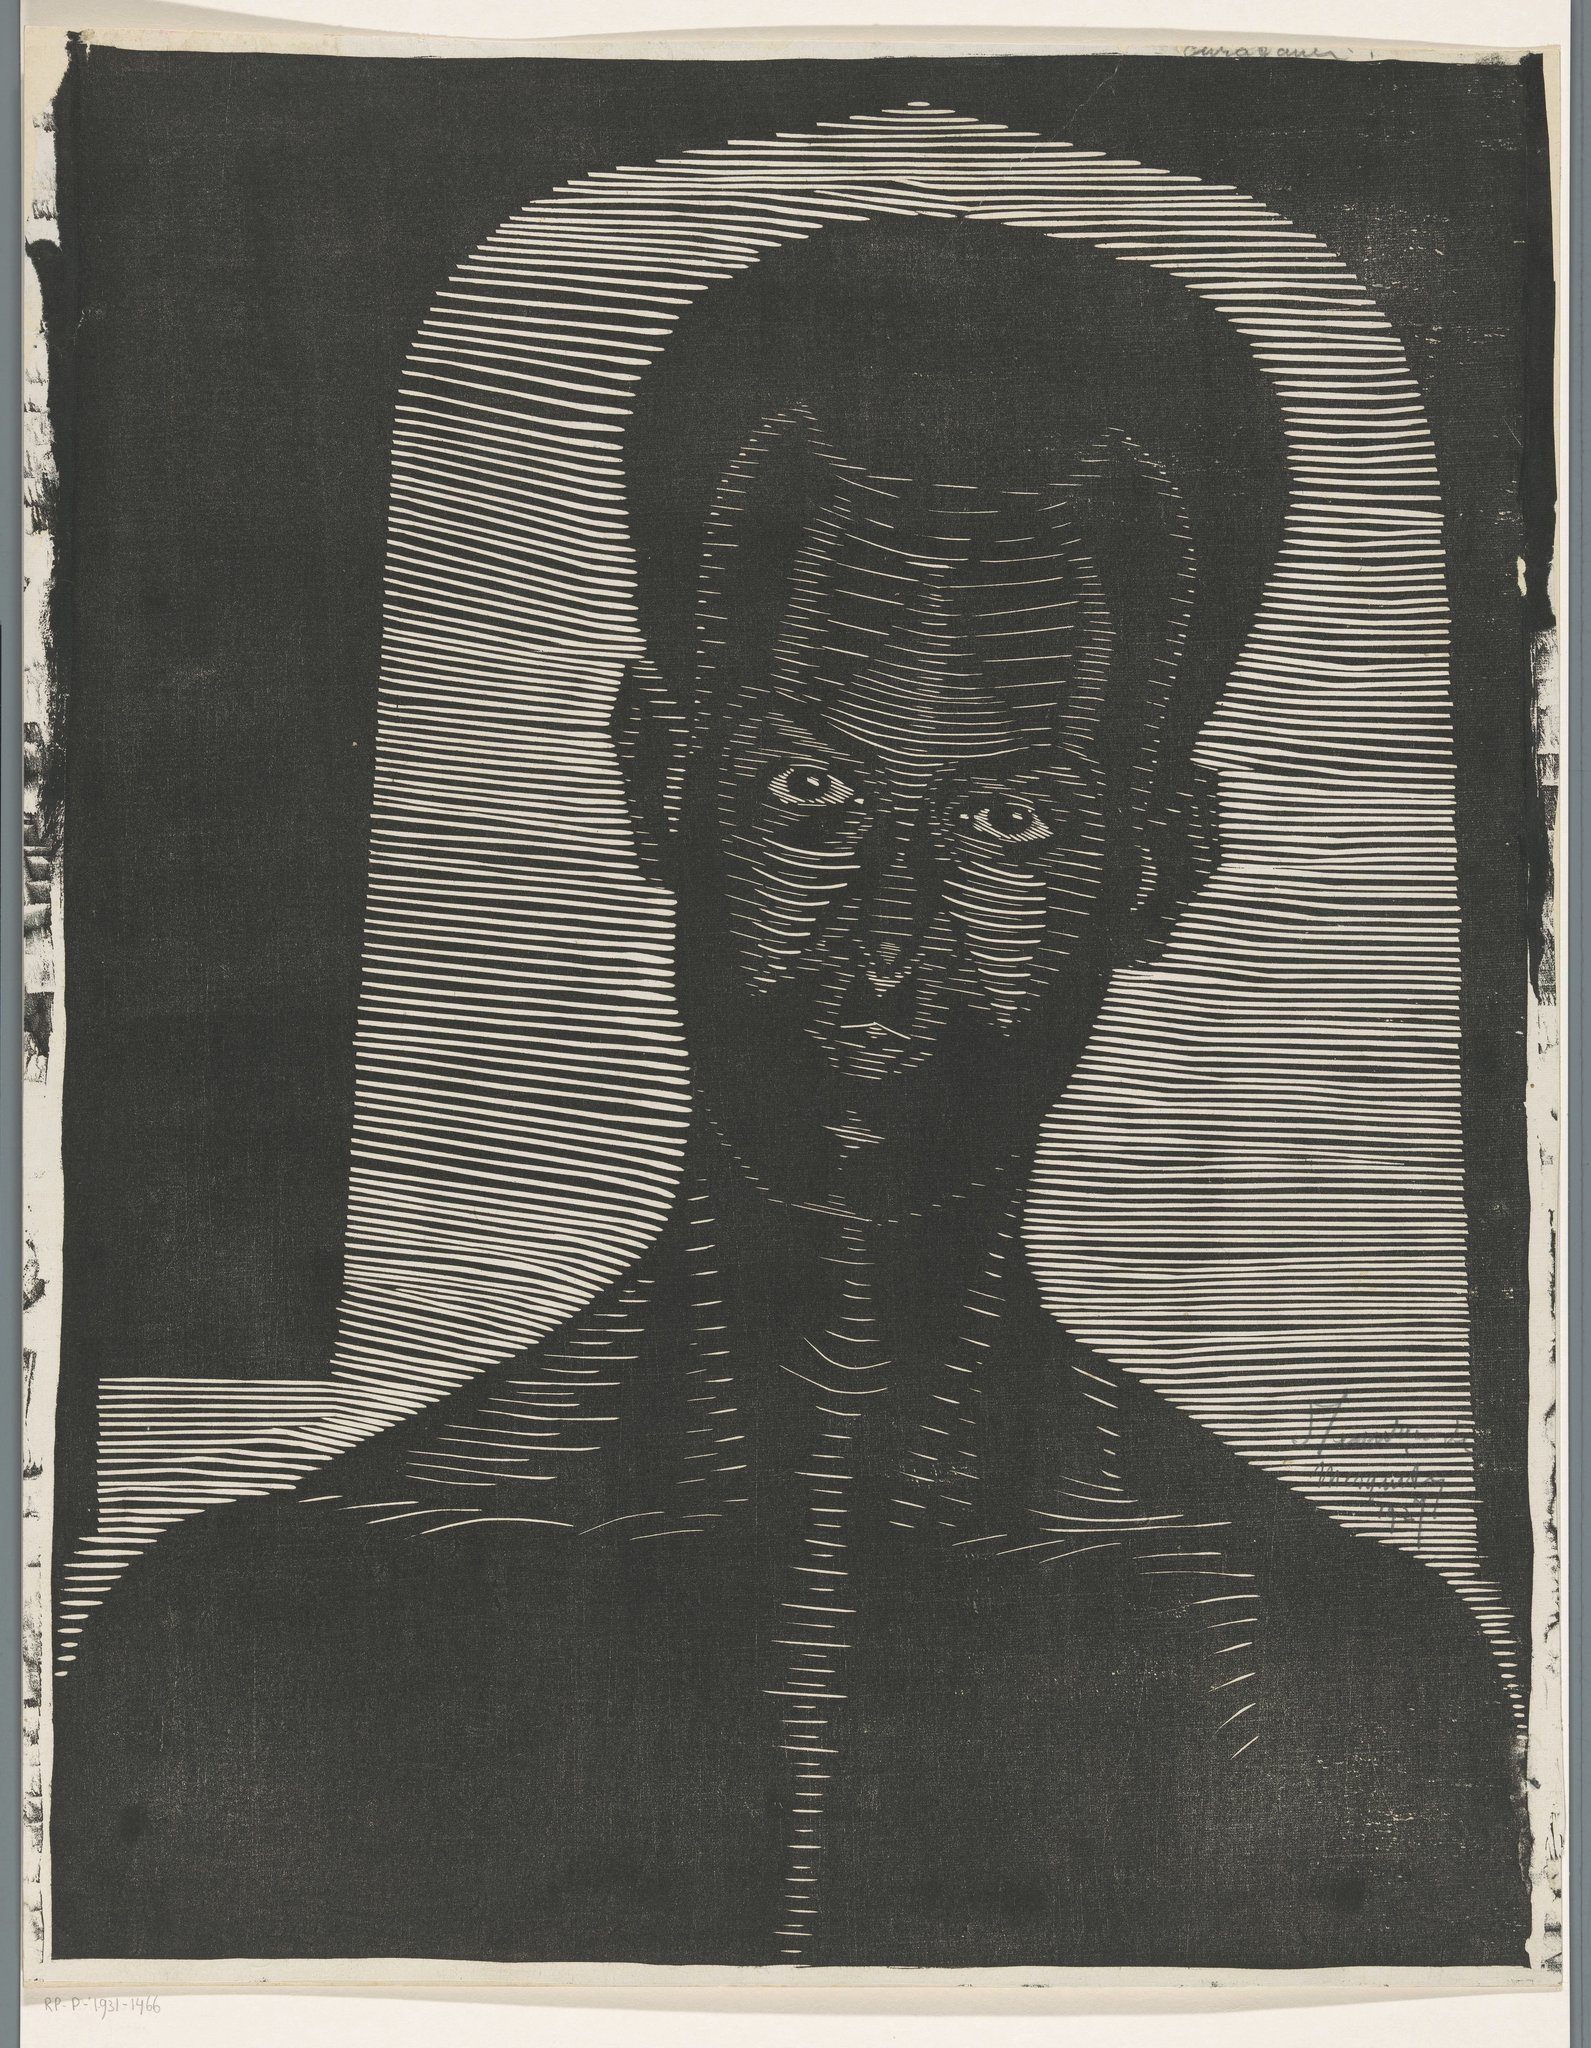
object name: print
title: Curaçauer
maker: samuel jessurun de mesquita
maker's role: draughtsman, print maker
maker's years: 1868-1944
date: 1927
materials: paper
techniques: woodcut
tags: youth, adolescent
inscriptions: number: ‘16’, collector's mark: Lugt 2228